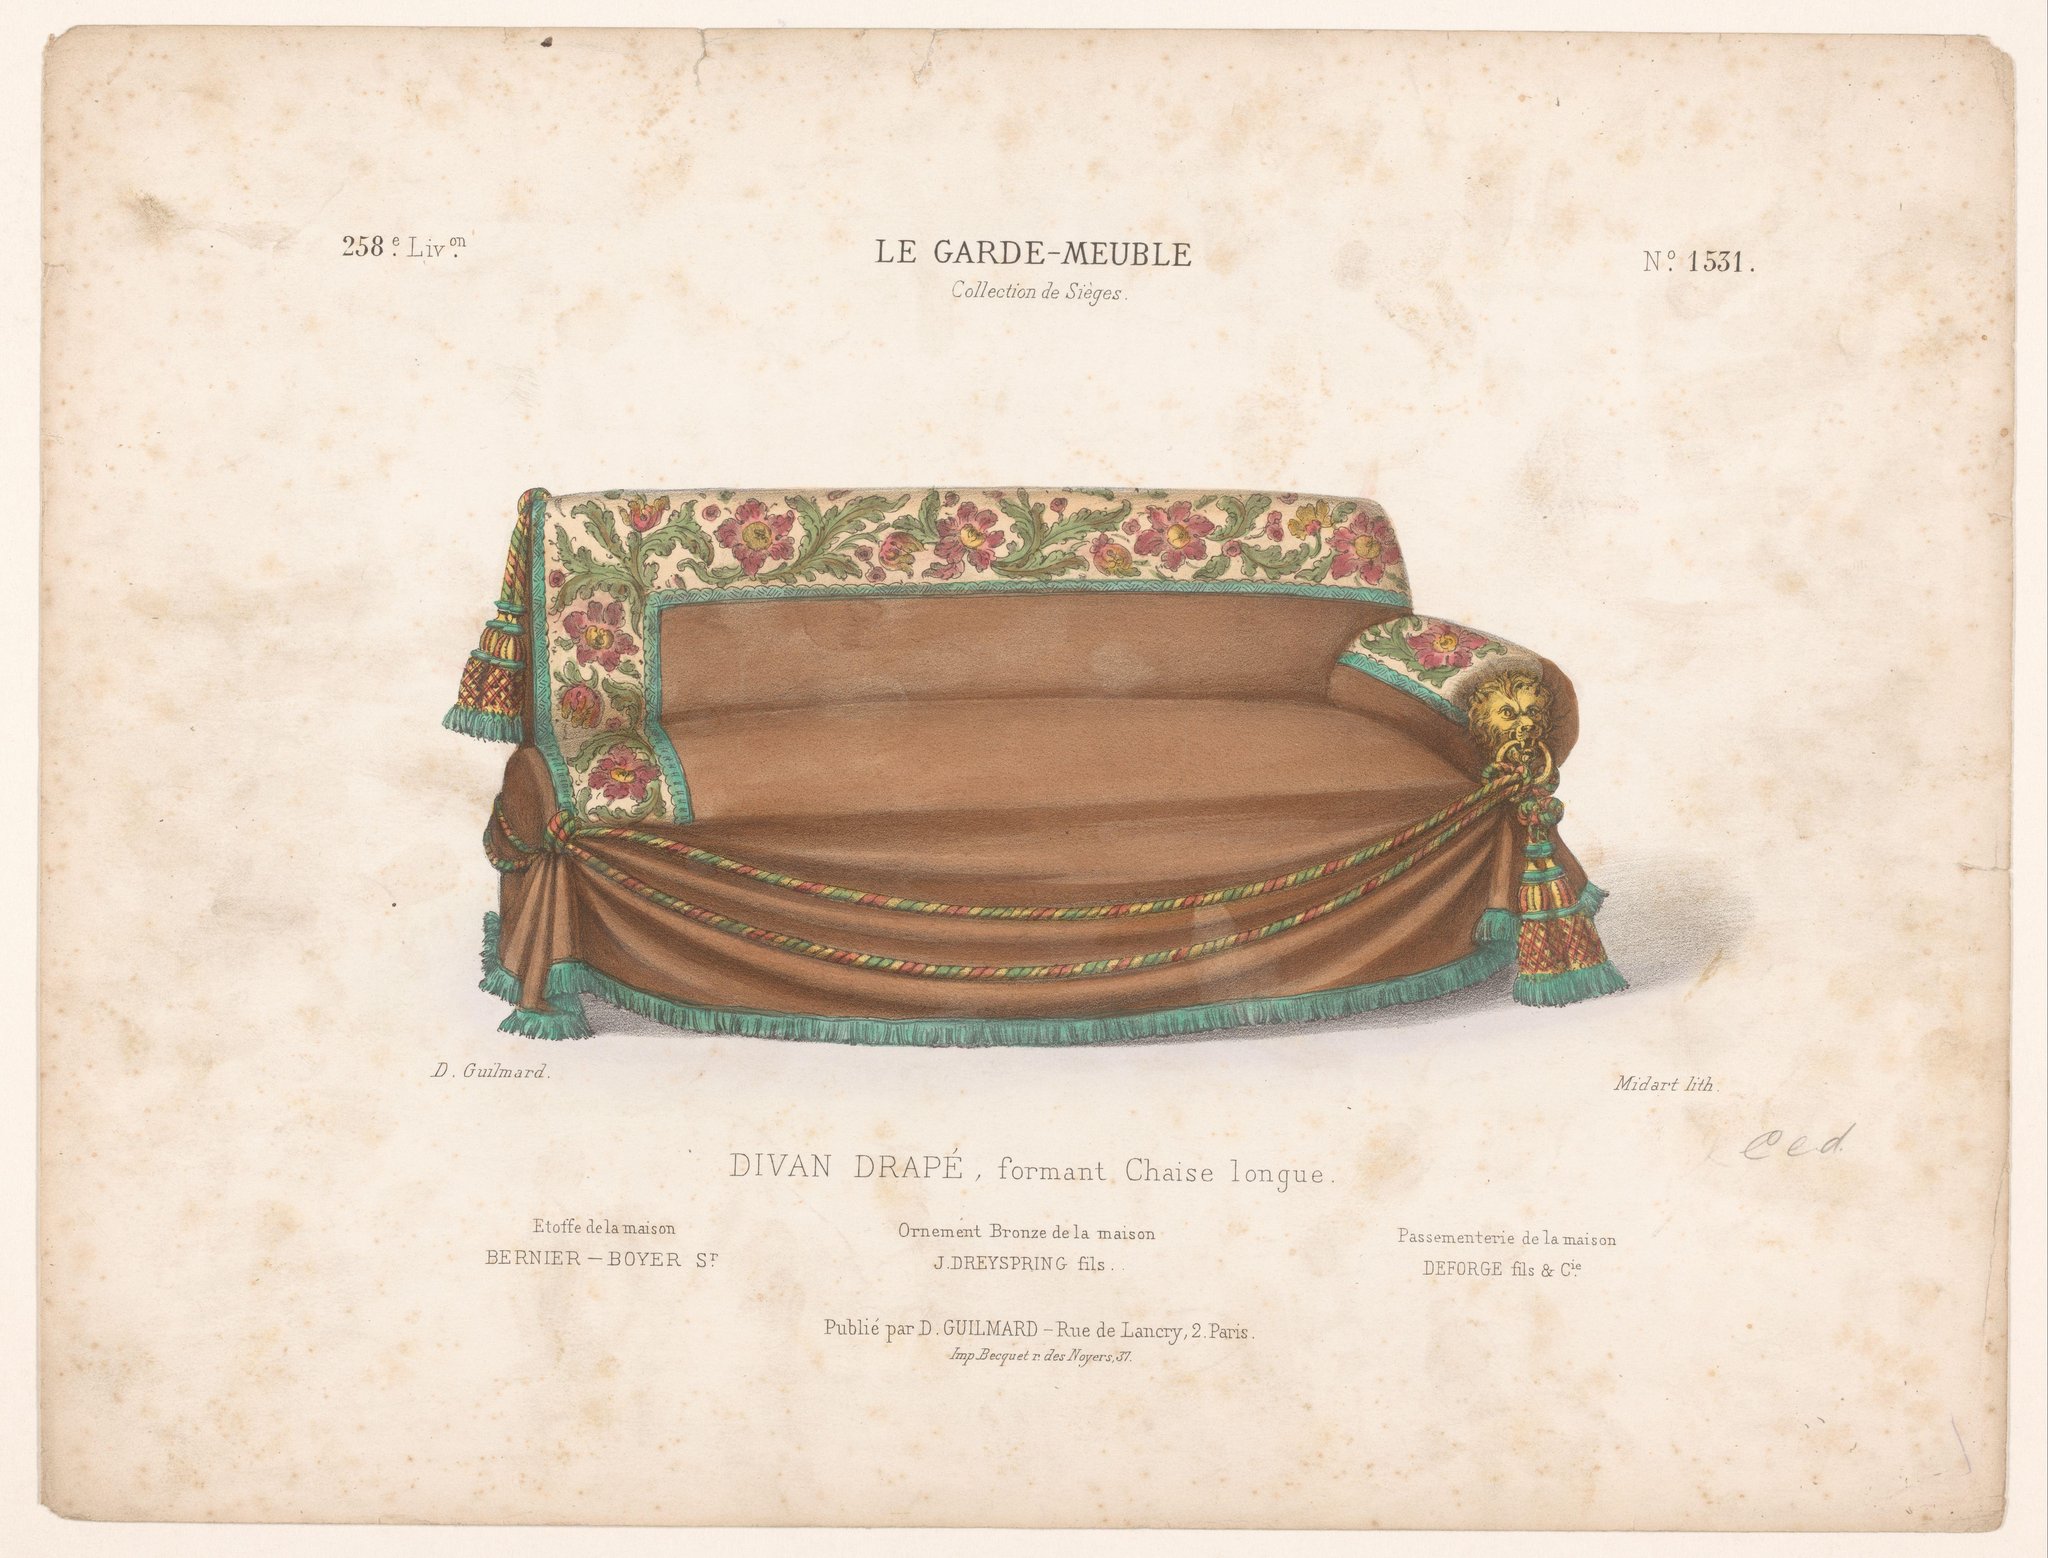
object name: print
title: Divan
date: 1839-1885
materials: paper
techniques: hand coloring, lithograph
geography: paris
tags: seating furniture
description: Ieder Livraison in de serie Le Garde-Meuble bevat negen platen: drie 'sièges' (zitmeubels), drie 'meubles' (diverse meubels zoals tafels en kasten) en drie 'tentures' (gordijnen en draperieën).